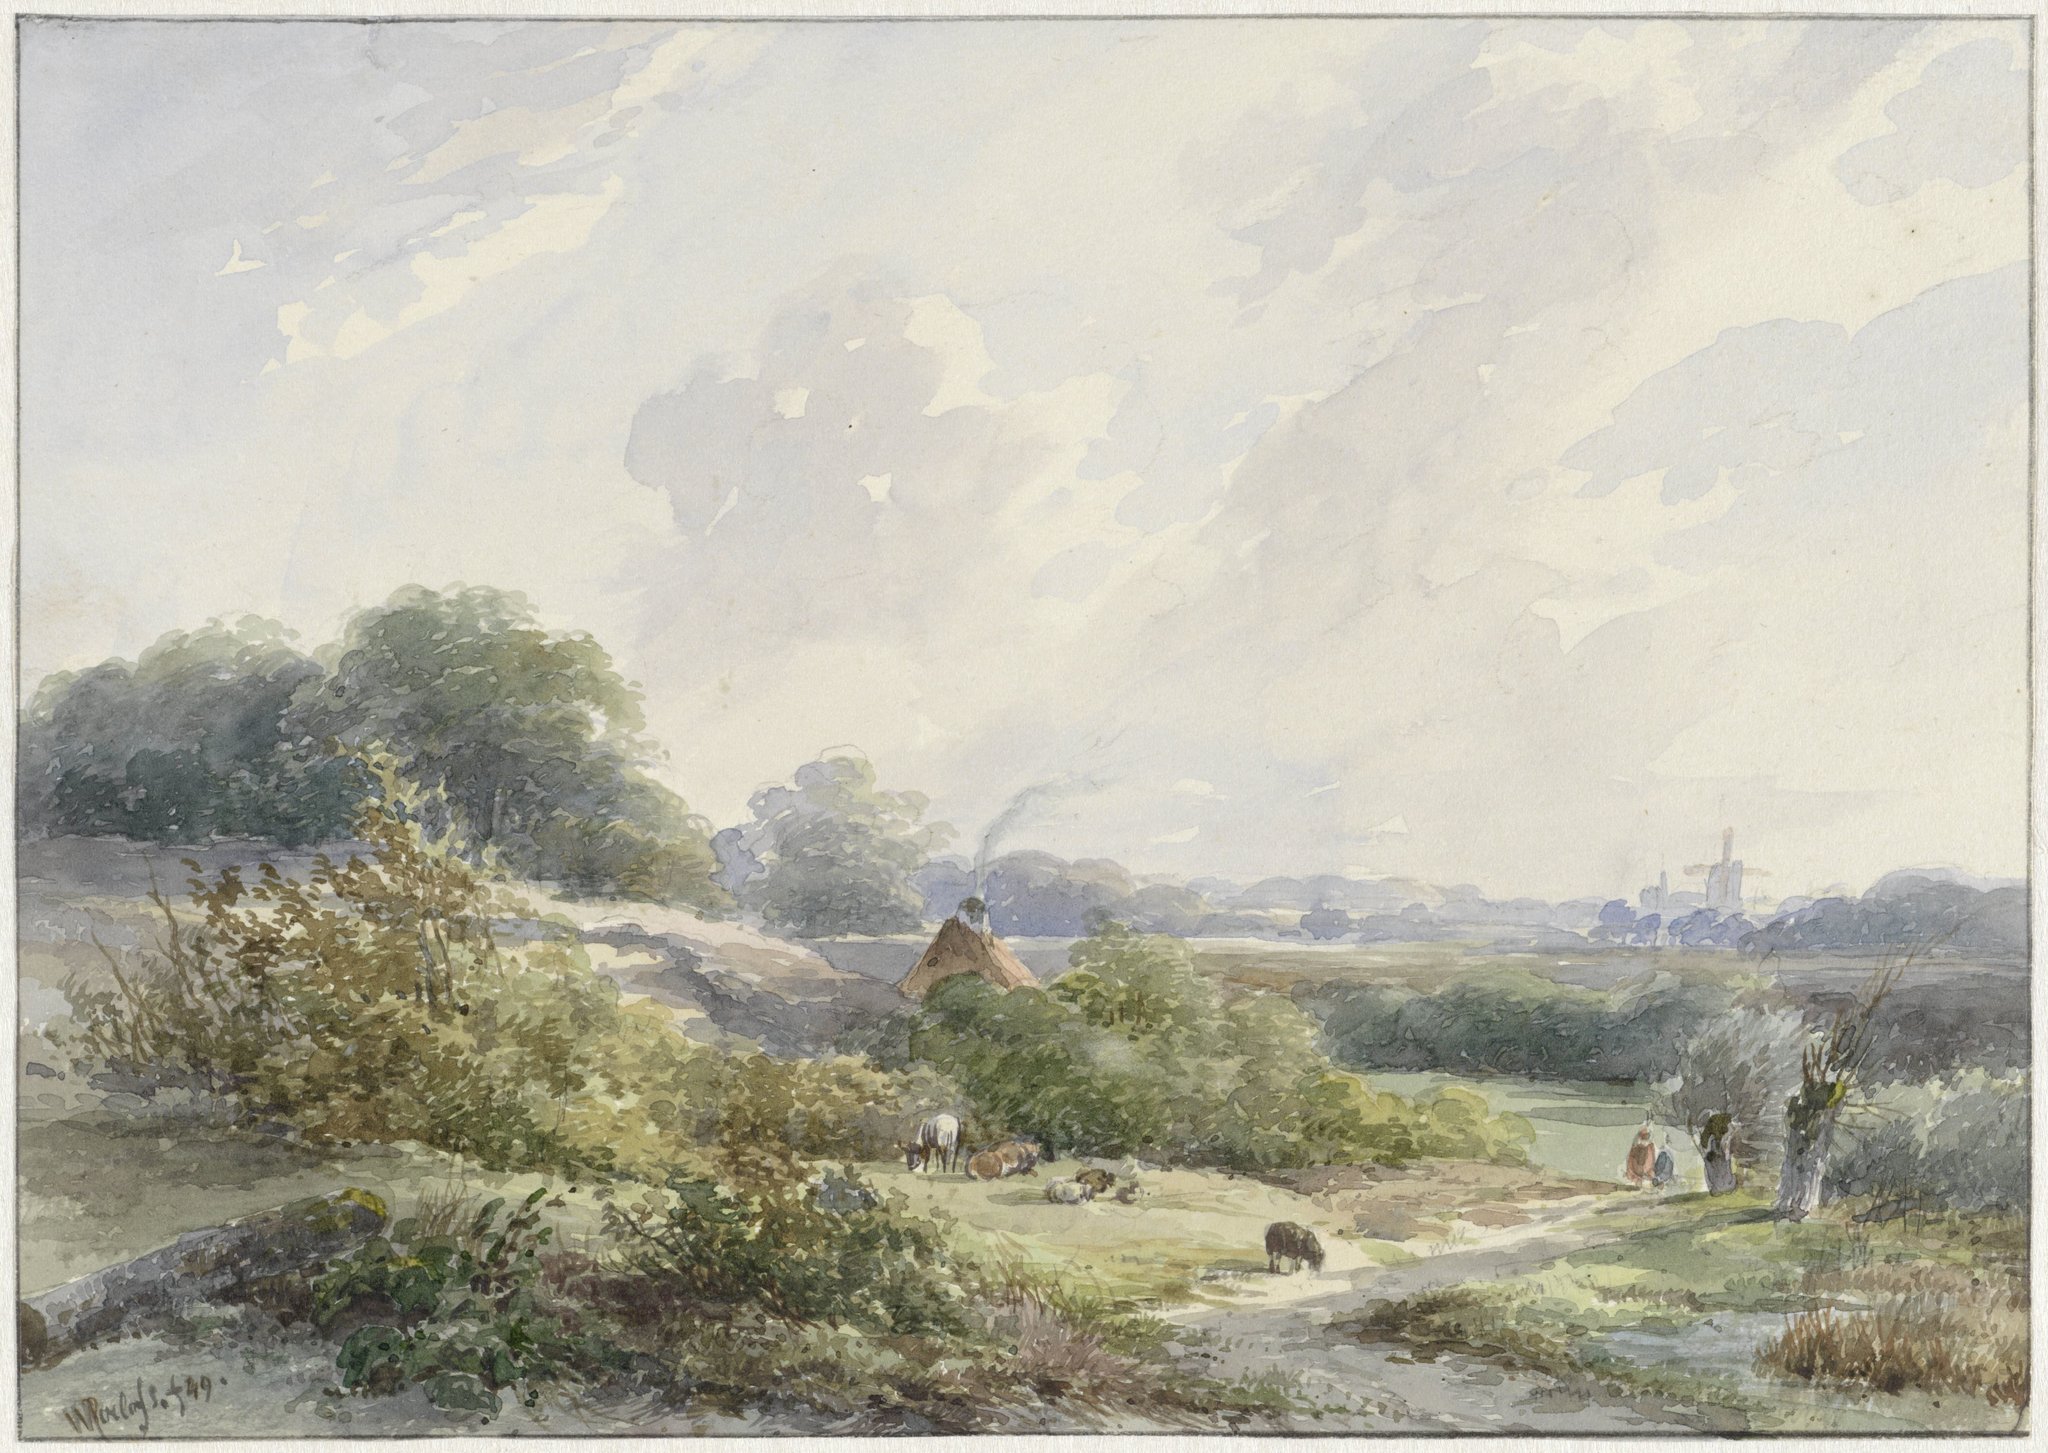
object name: watercolor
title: Landschap met boerderij en vee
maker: willem roelofs (i)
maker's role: draughtsman, painter, print maker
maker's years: 1822-1897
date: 1849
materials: paper, pencil, watercolor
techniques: brush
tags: farm or solitary house in landscape